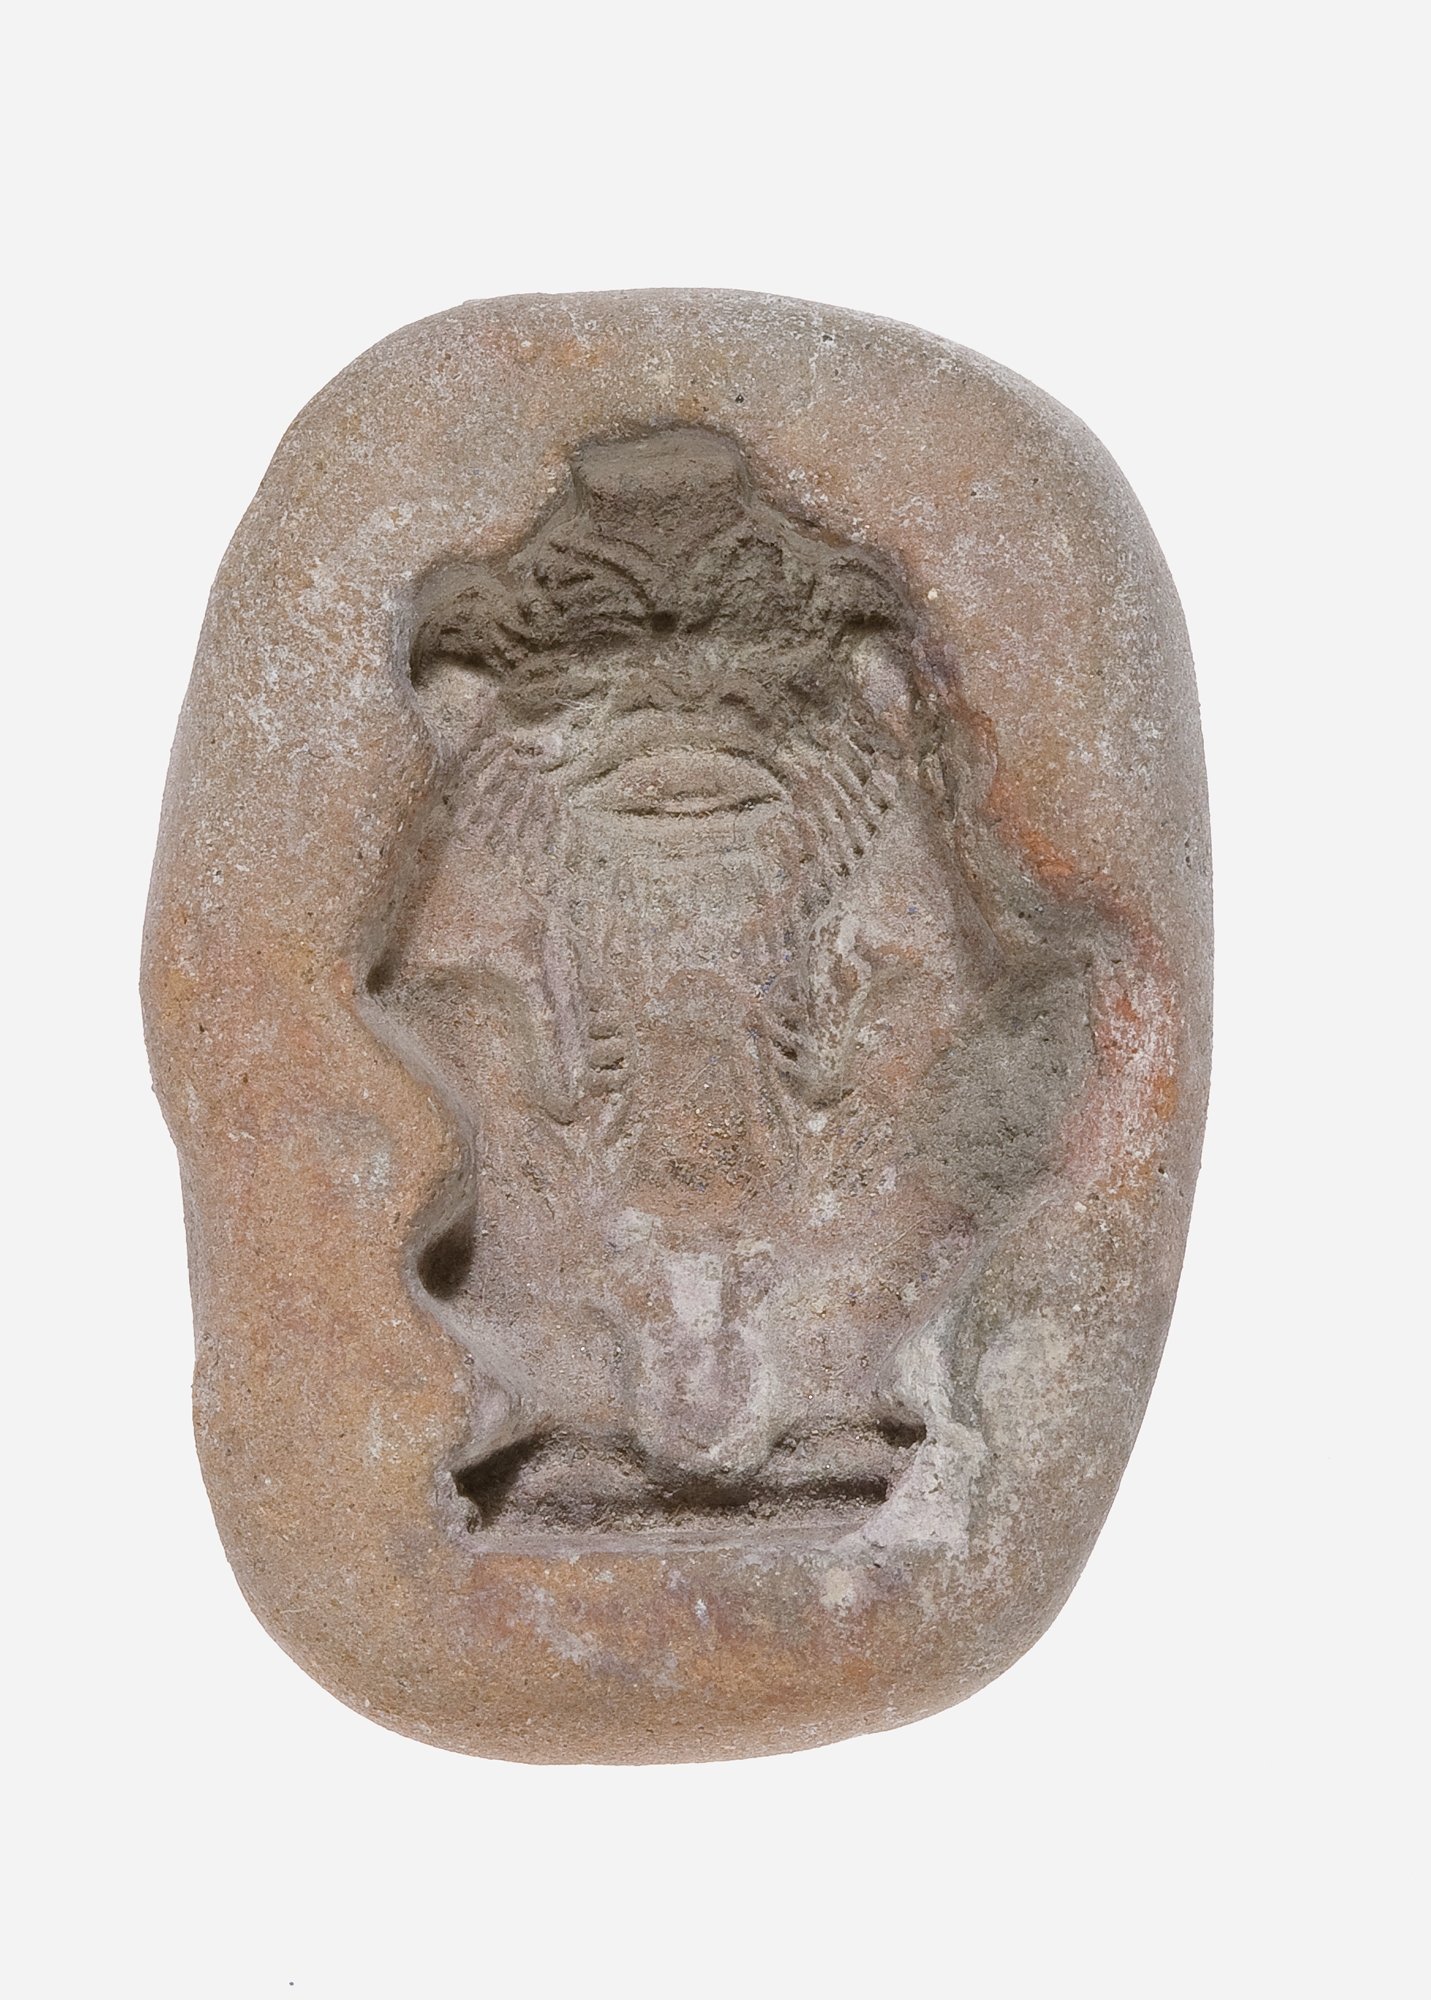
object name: mold, amulet, be image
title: Mold for Bes-image Amulet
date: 1390-1352 BCE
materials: pottery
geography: egypt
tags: bes